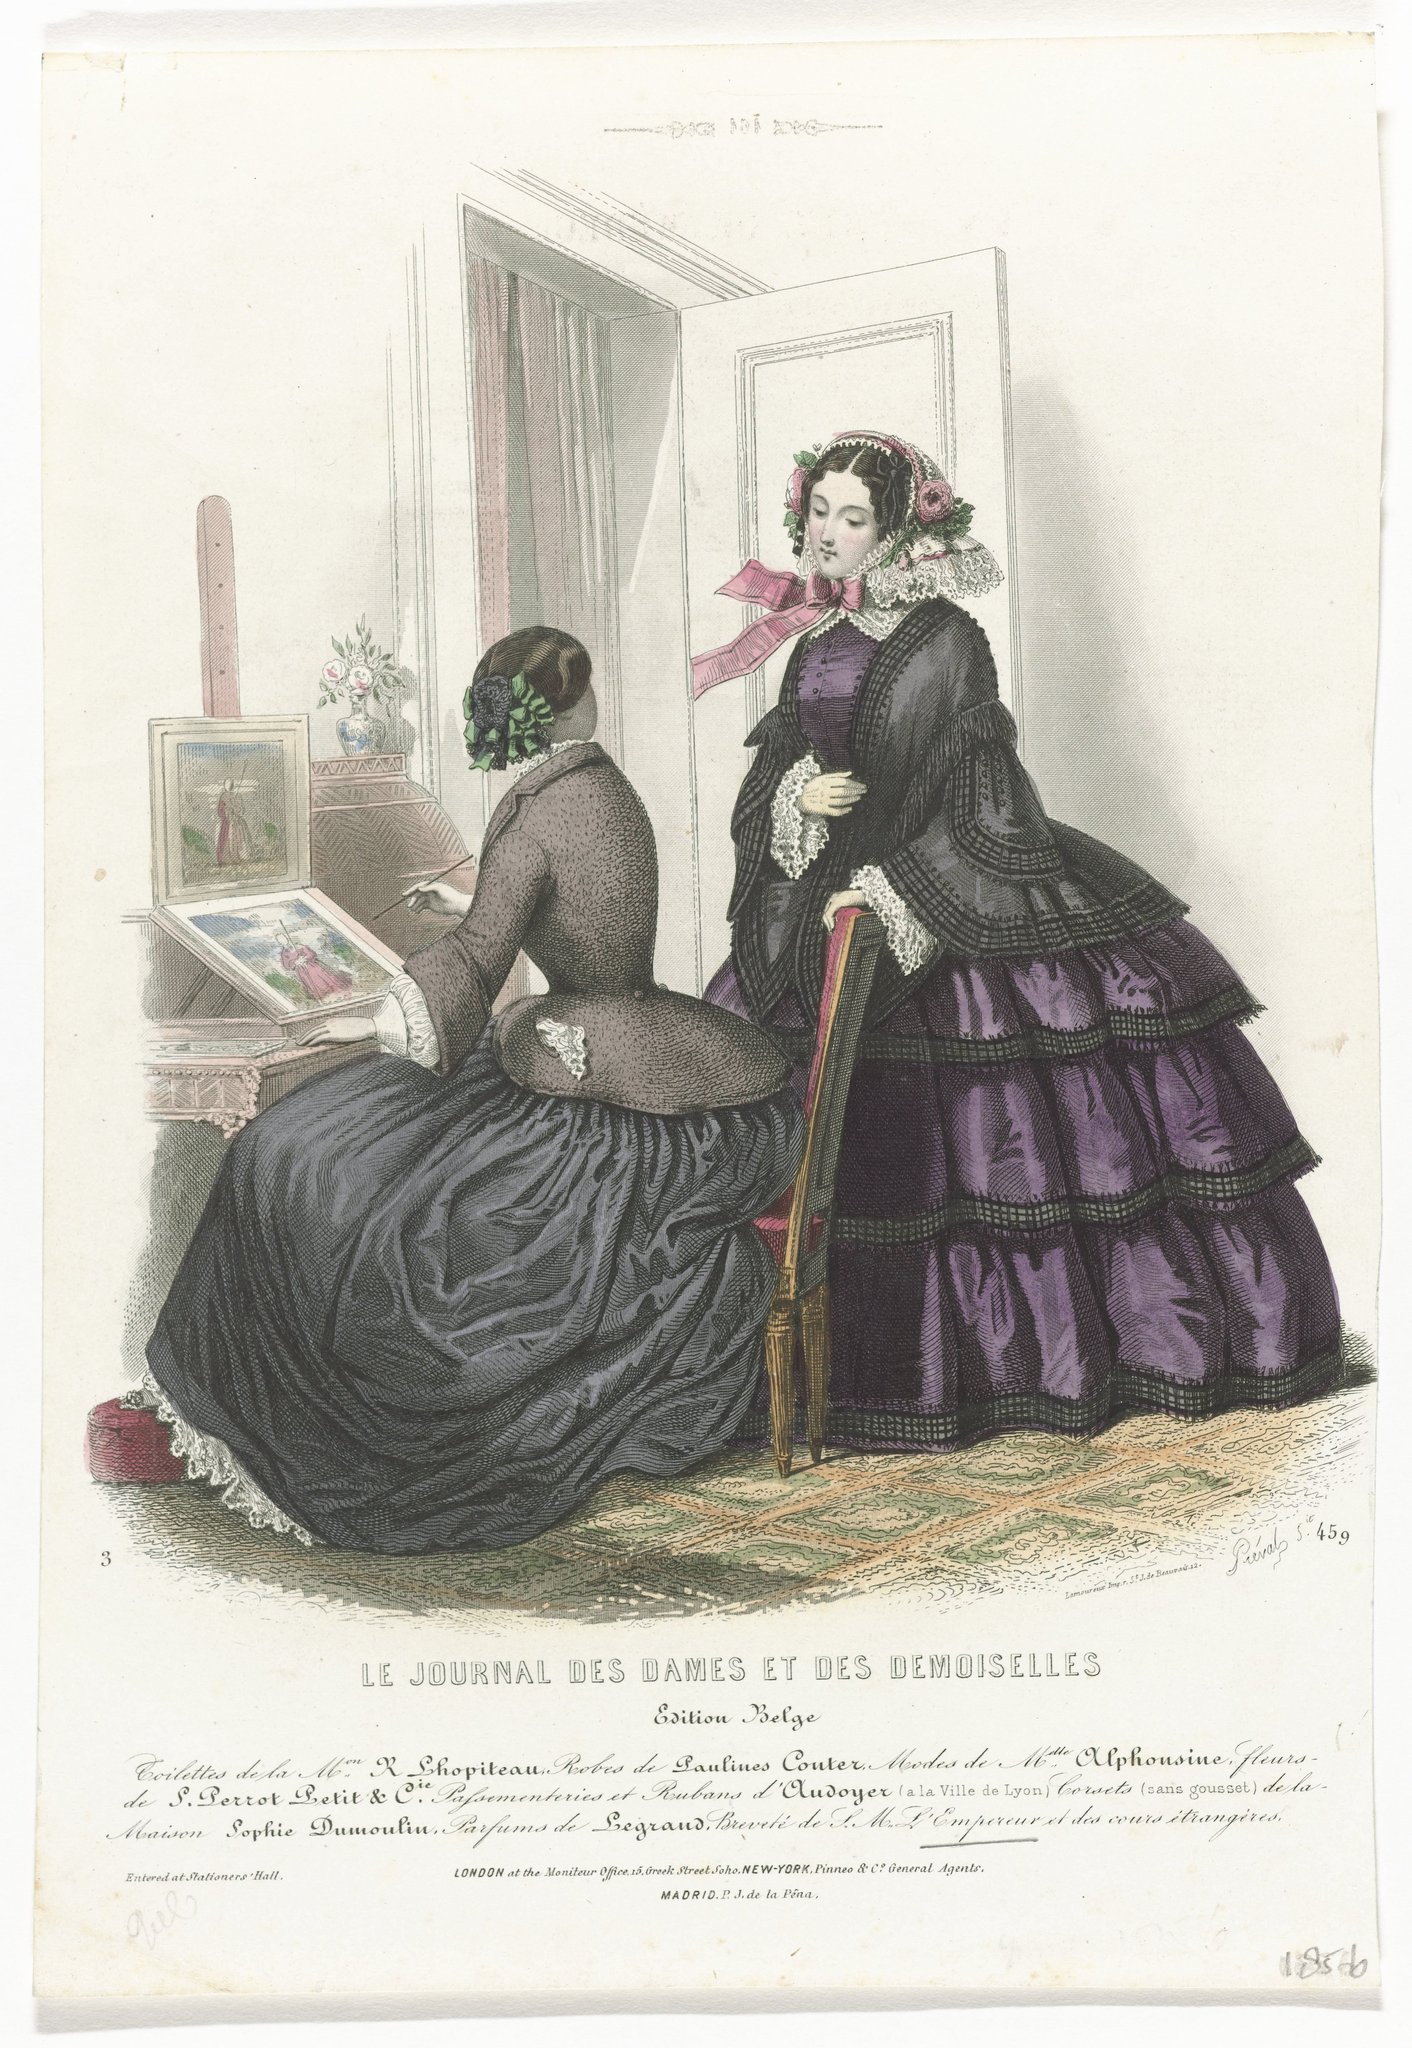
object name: fashion print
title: Le Journal des Dames et des Demoiselles, 1856 No. 459, Edition Belge : Toilettes (...)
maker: préval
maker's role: print maker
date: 1856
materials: paper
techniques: hand coloring, engraving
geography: paris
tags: ornamental parts of clothing (+ women's clothes), coat (+ women's clothes), head-gear (+ women's clothes), fashion plates, skirt (+ women's clothes), gloves, mittens, etc. (+ women's clothes), painting (including book-illumination, miniature-painting) (+ artist at work), neck-gear ~ clothing (+ women's clothes), sleeves (+ women's clothes)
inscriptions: title: ‘Le Journal des Dames et des Demoiselles / Edition Belge’, address: ‘London at the Moniteur Office 15 Greek Street Soho. New-York Pinneo & Co. General Agents. Madrid P.J. de la Pêna.’, caption: ‘Toilettes de la M"on R Lhopiteau. Robes de Paulines Couter. Modes de M"elle Alphonsine. fleurs-de S. Perrot Petit & C.ie. Passementeries et Rubans d'Audoyer (a la Ville de Lyon) Corsets (sans gousset) de la Maison Sophie Dumoulin. Parfums de Legrand, Breveté de S.M. L'Empereur et des cours étrangéres.’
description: Twee vrouwen in een interieur, van wie één achter een tafel aan het schilderen is. Volgens het onderschrift: 'toilettes' van LHopiteau. Japonnen van Paulines Couter. 'Modes' van Alphousine. Hieronder enkele regels reclametekst voor verschillende producten. Prent uit het modetijdschrift Journal des Dames et des Demoiselles (1841-1902).